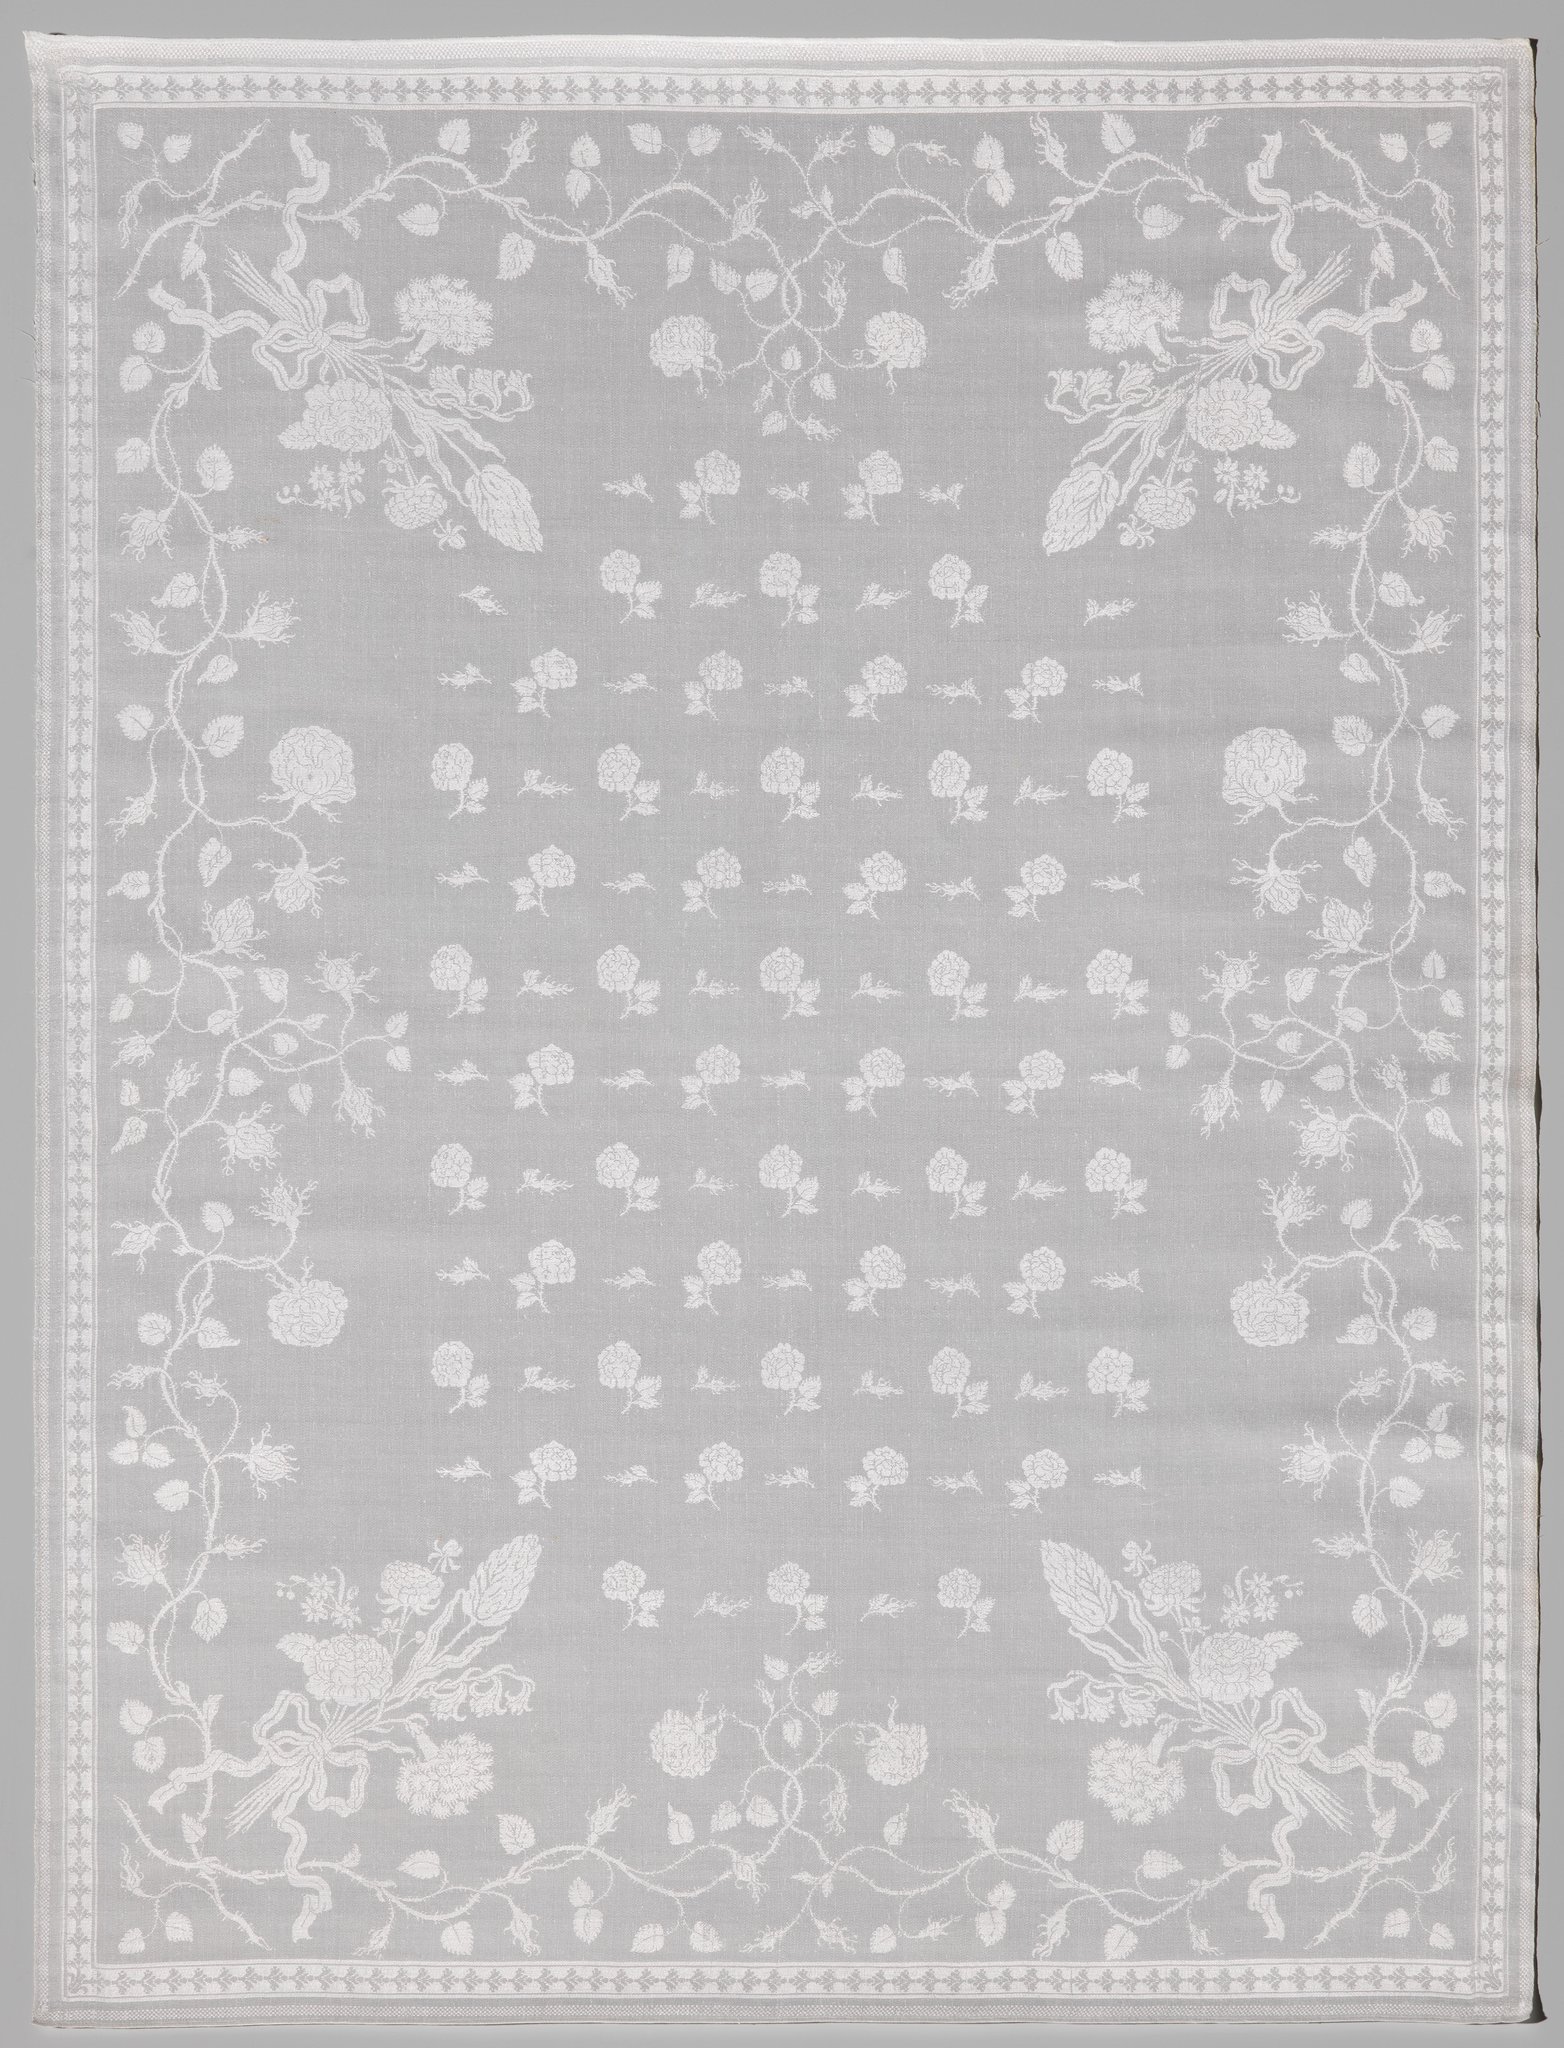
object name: napkin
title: Servet van wit linnendamast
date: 1767-1816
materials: linen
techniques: damask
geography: netherlands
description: Wit linnenendamasten servet met een patroon van gestrooide rozetakjes en rozeknop in verband, merk WS 24.